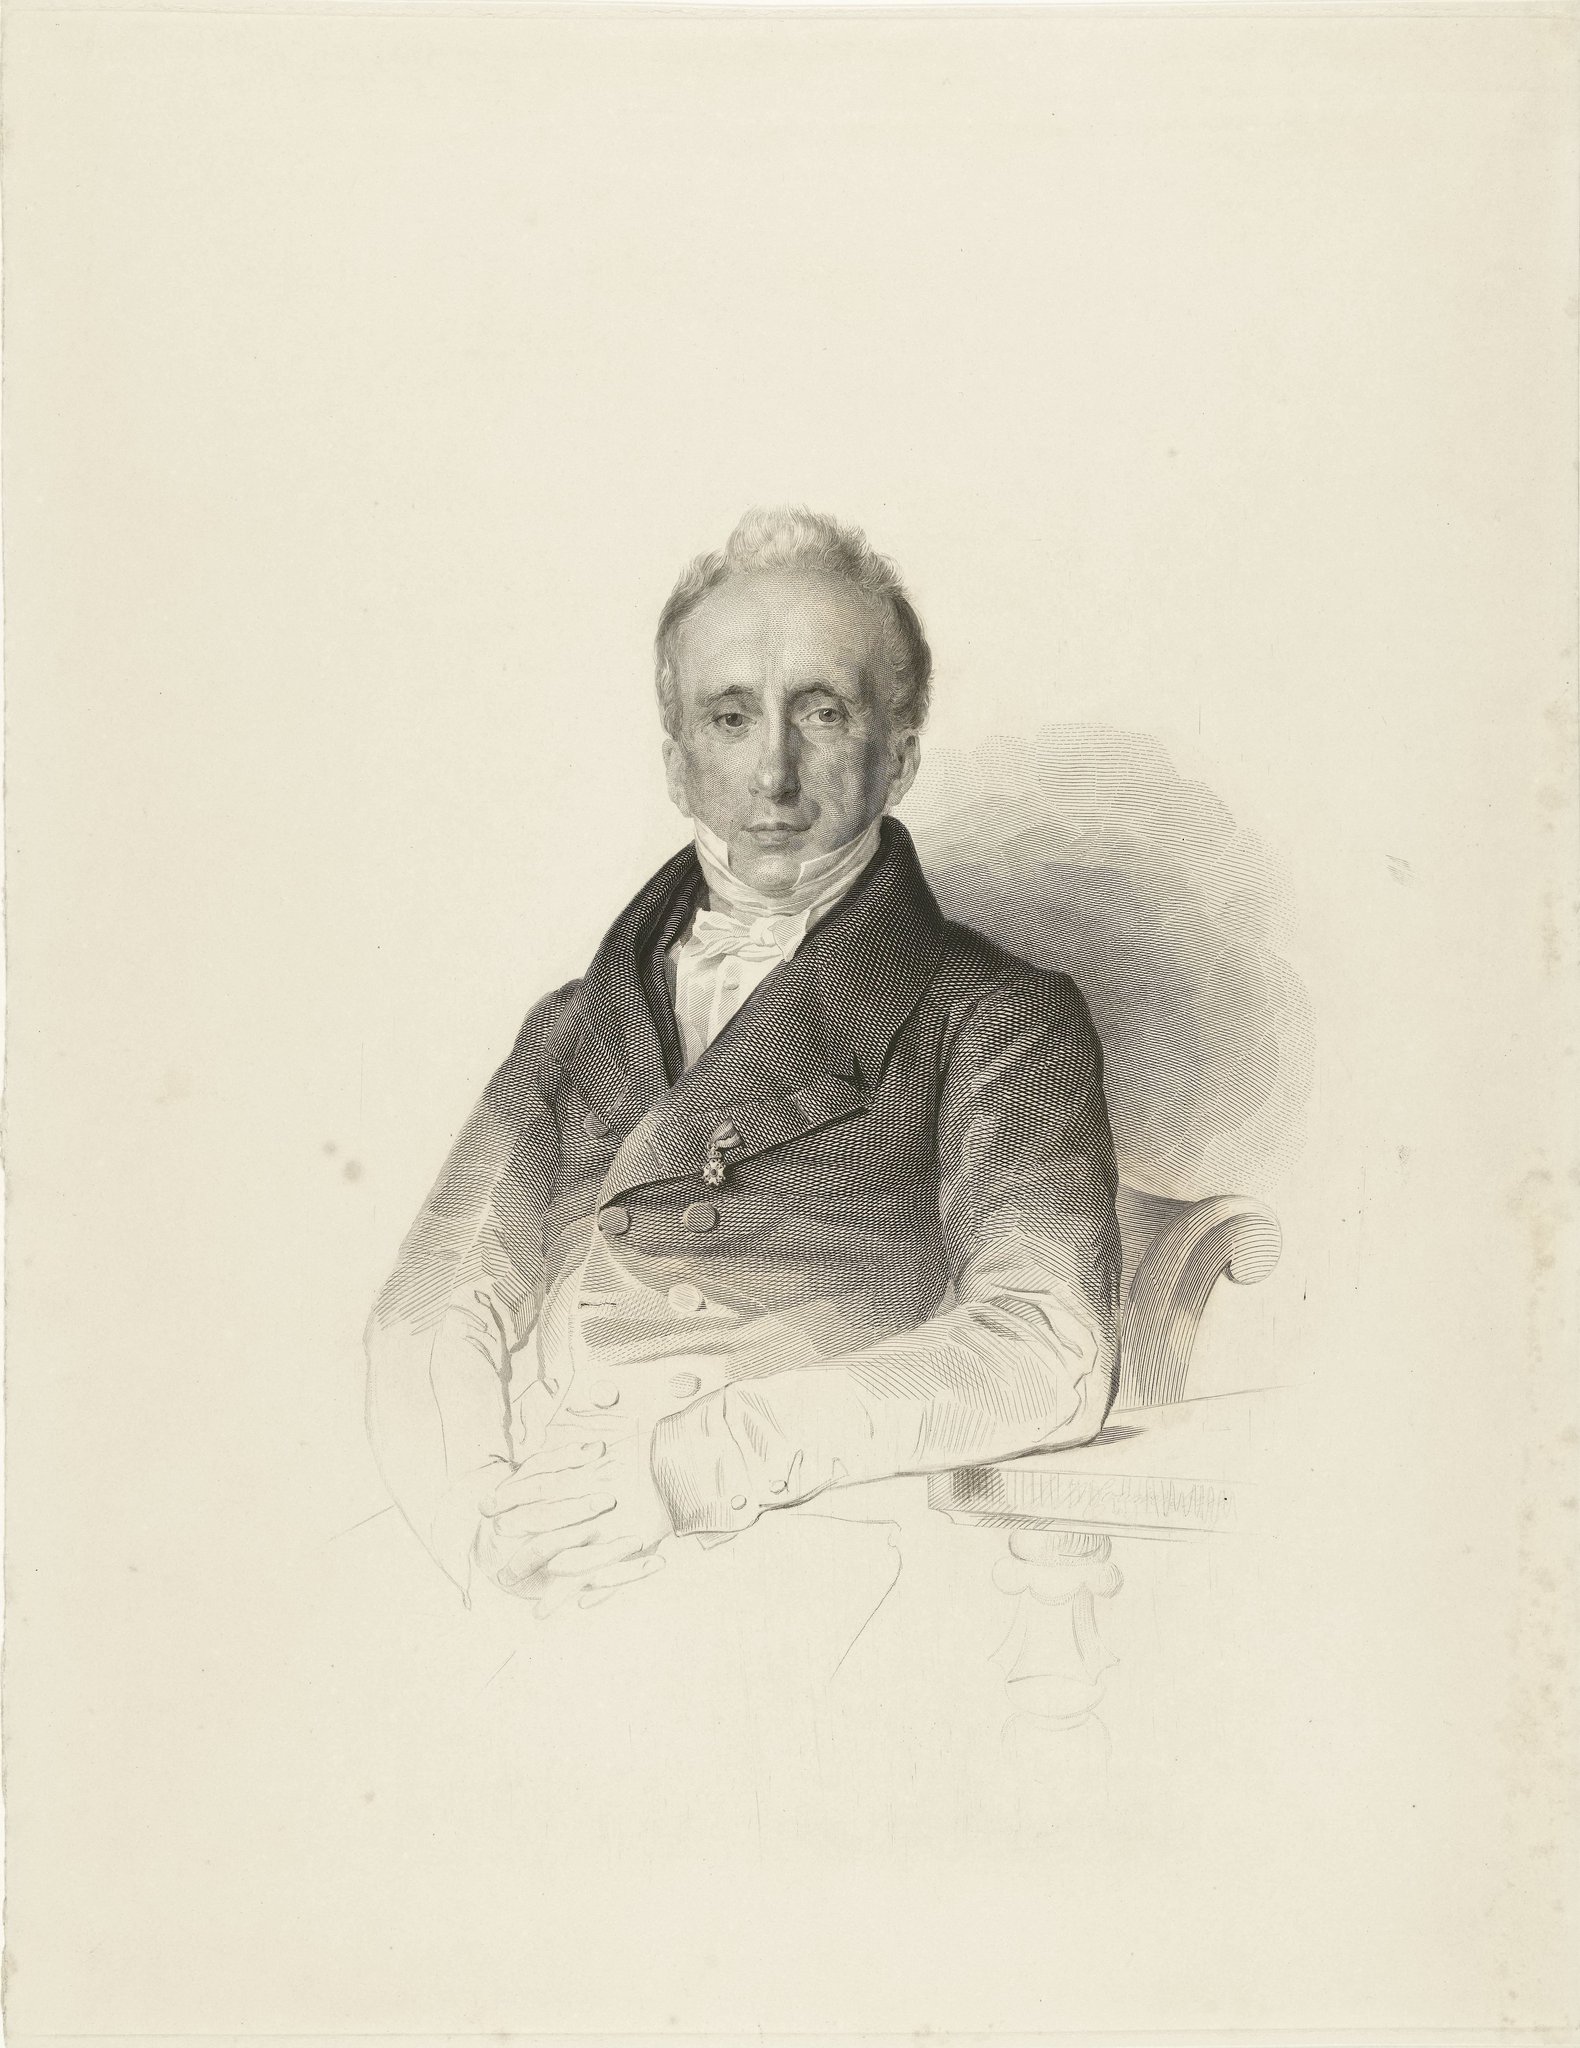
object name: print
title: Portret van Jacob Mendes de Leon, lid van de Amsterdamse gemeenteraad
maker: henricus wilhelmus couwenberg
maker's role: draughtsman, print maker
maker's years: 1814-1845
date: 1843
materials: paper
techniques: engraving, roulette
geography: amsterdam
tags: jacob mendes de leon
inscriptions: collector's mark: Lugt 2228